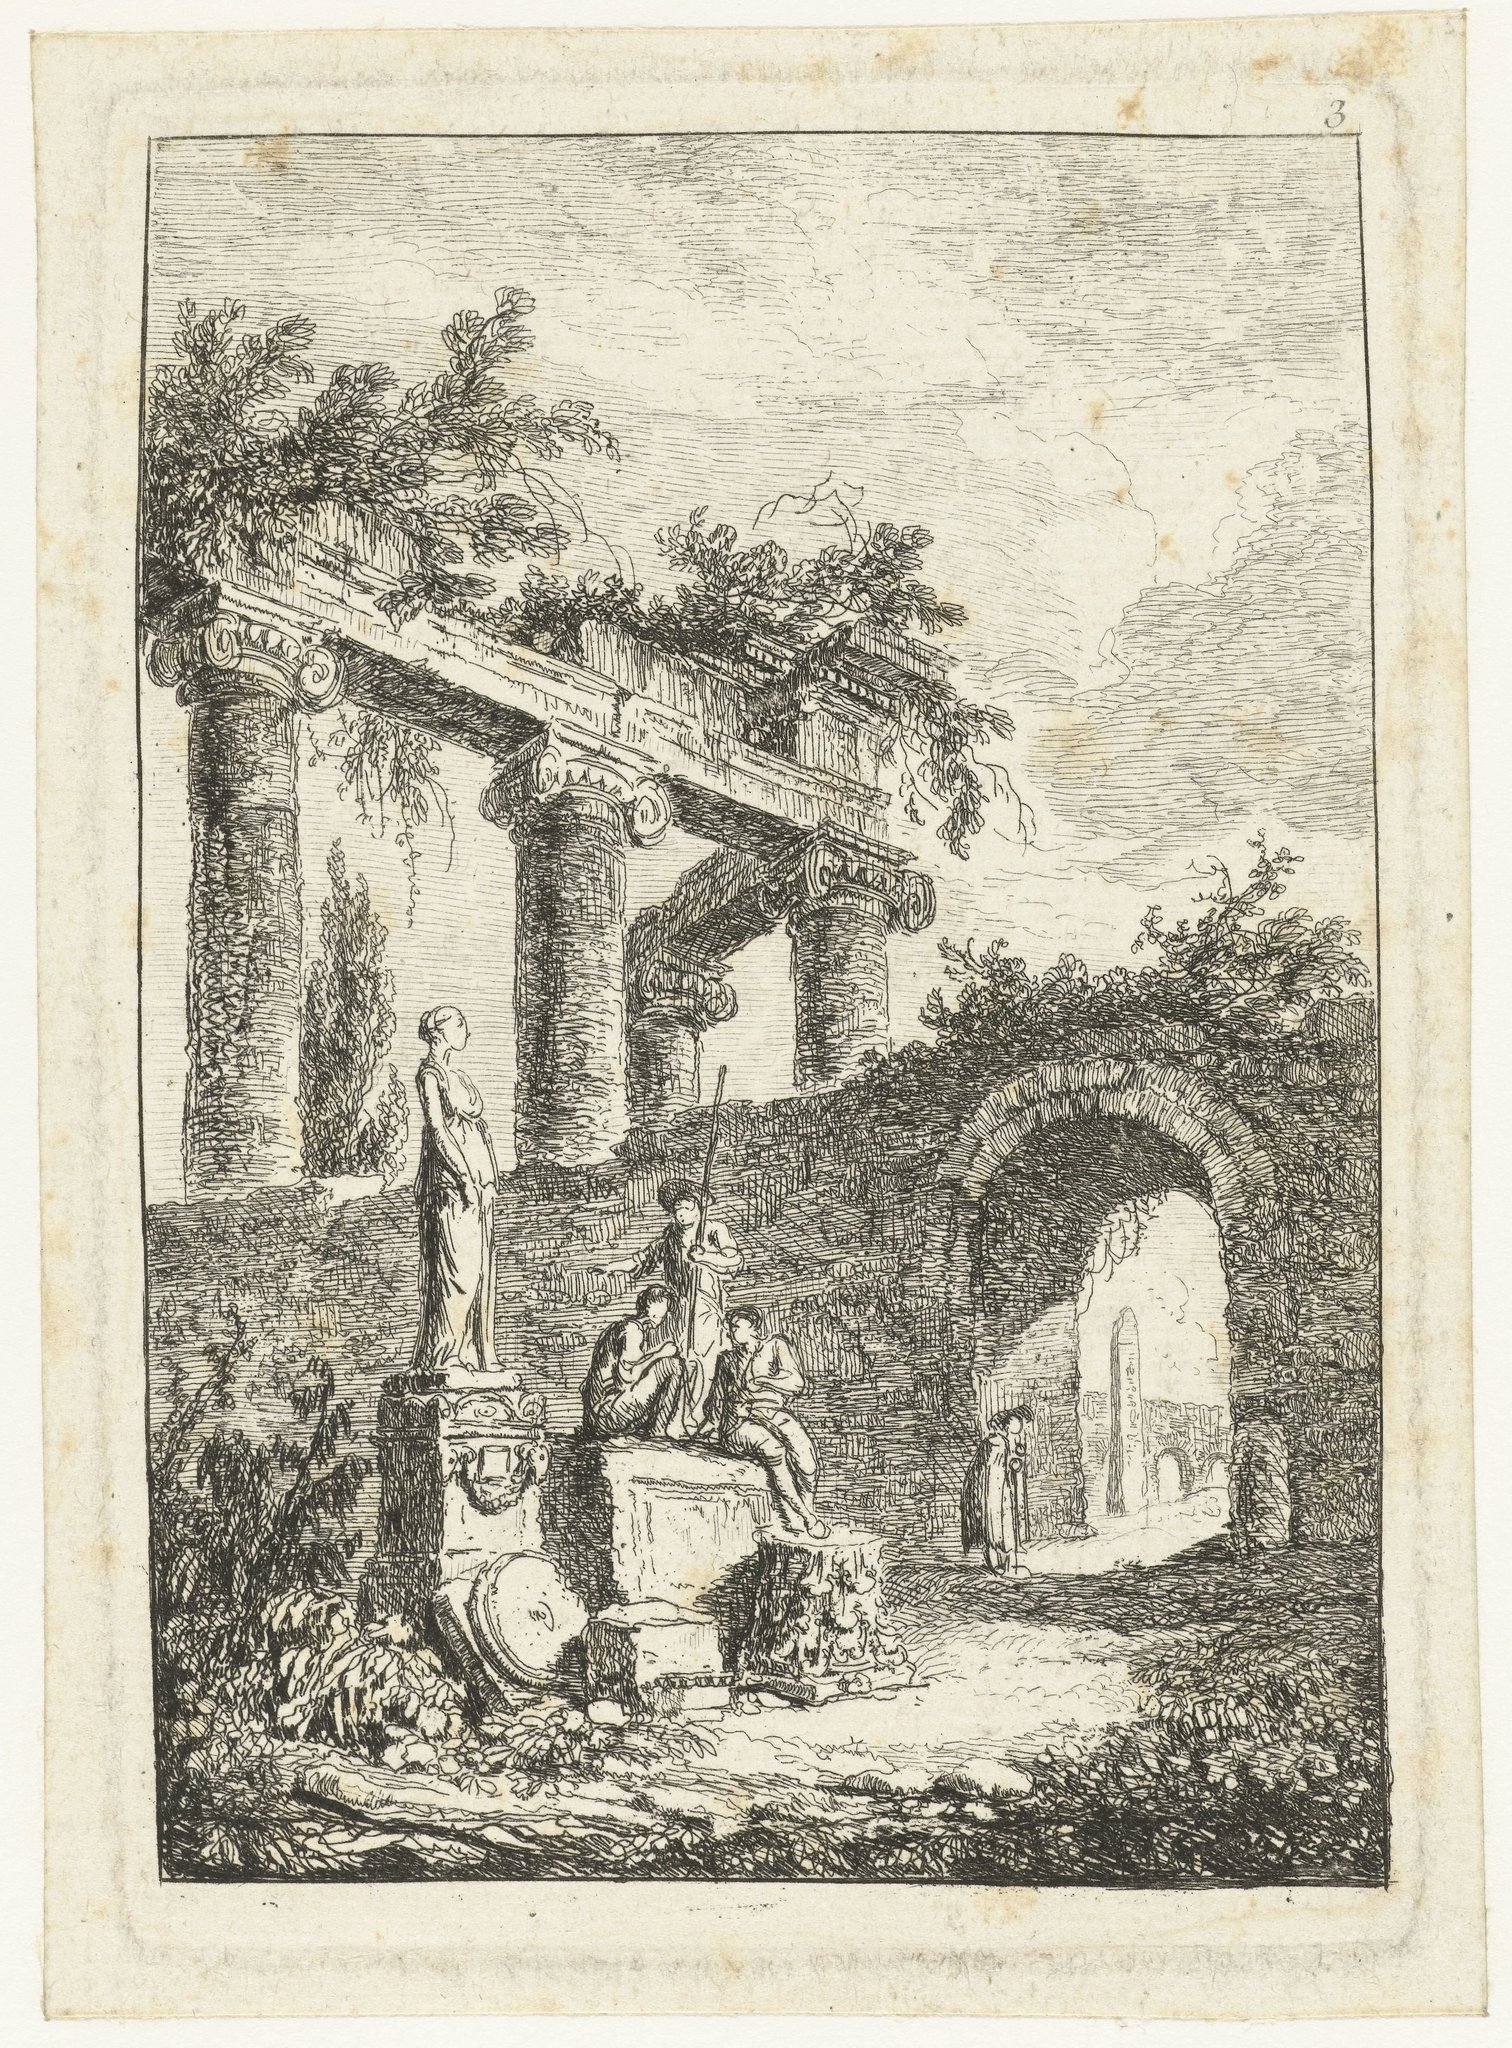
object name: print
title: Les Soireés de Rome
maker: hubert robert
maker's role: draughtsman, print maker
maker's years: 1733-1808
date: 1764-1766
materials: paper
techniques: etching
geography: rome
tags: landscape with ruins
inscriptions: collector's mark: Lugt 2760, collector's mark: Lugt 2228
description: Drie mannen bij antieke resten en naast een beeld op een sokkel. Achter een muur hoge zuilen van een ruïne. Derde prent uit een serie van tien.